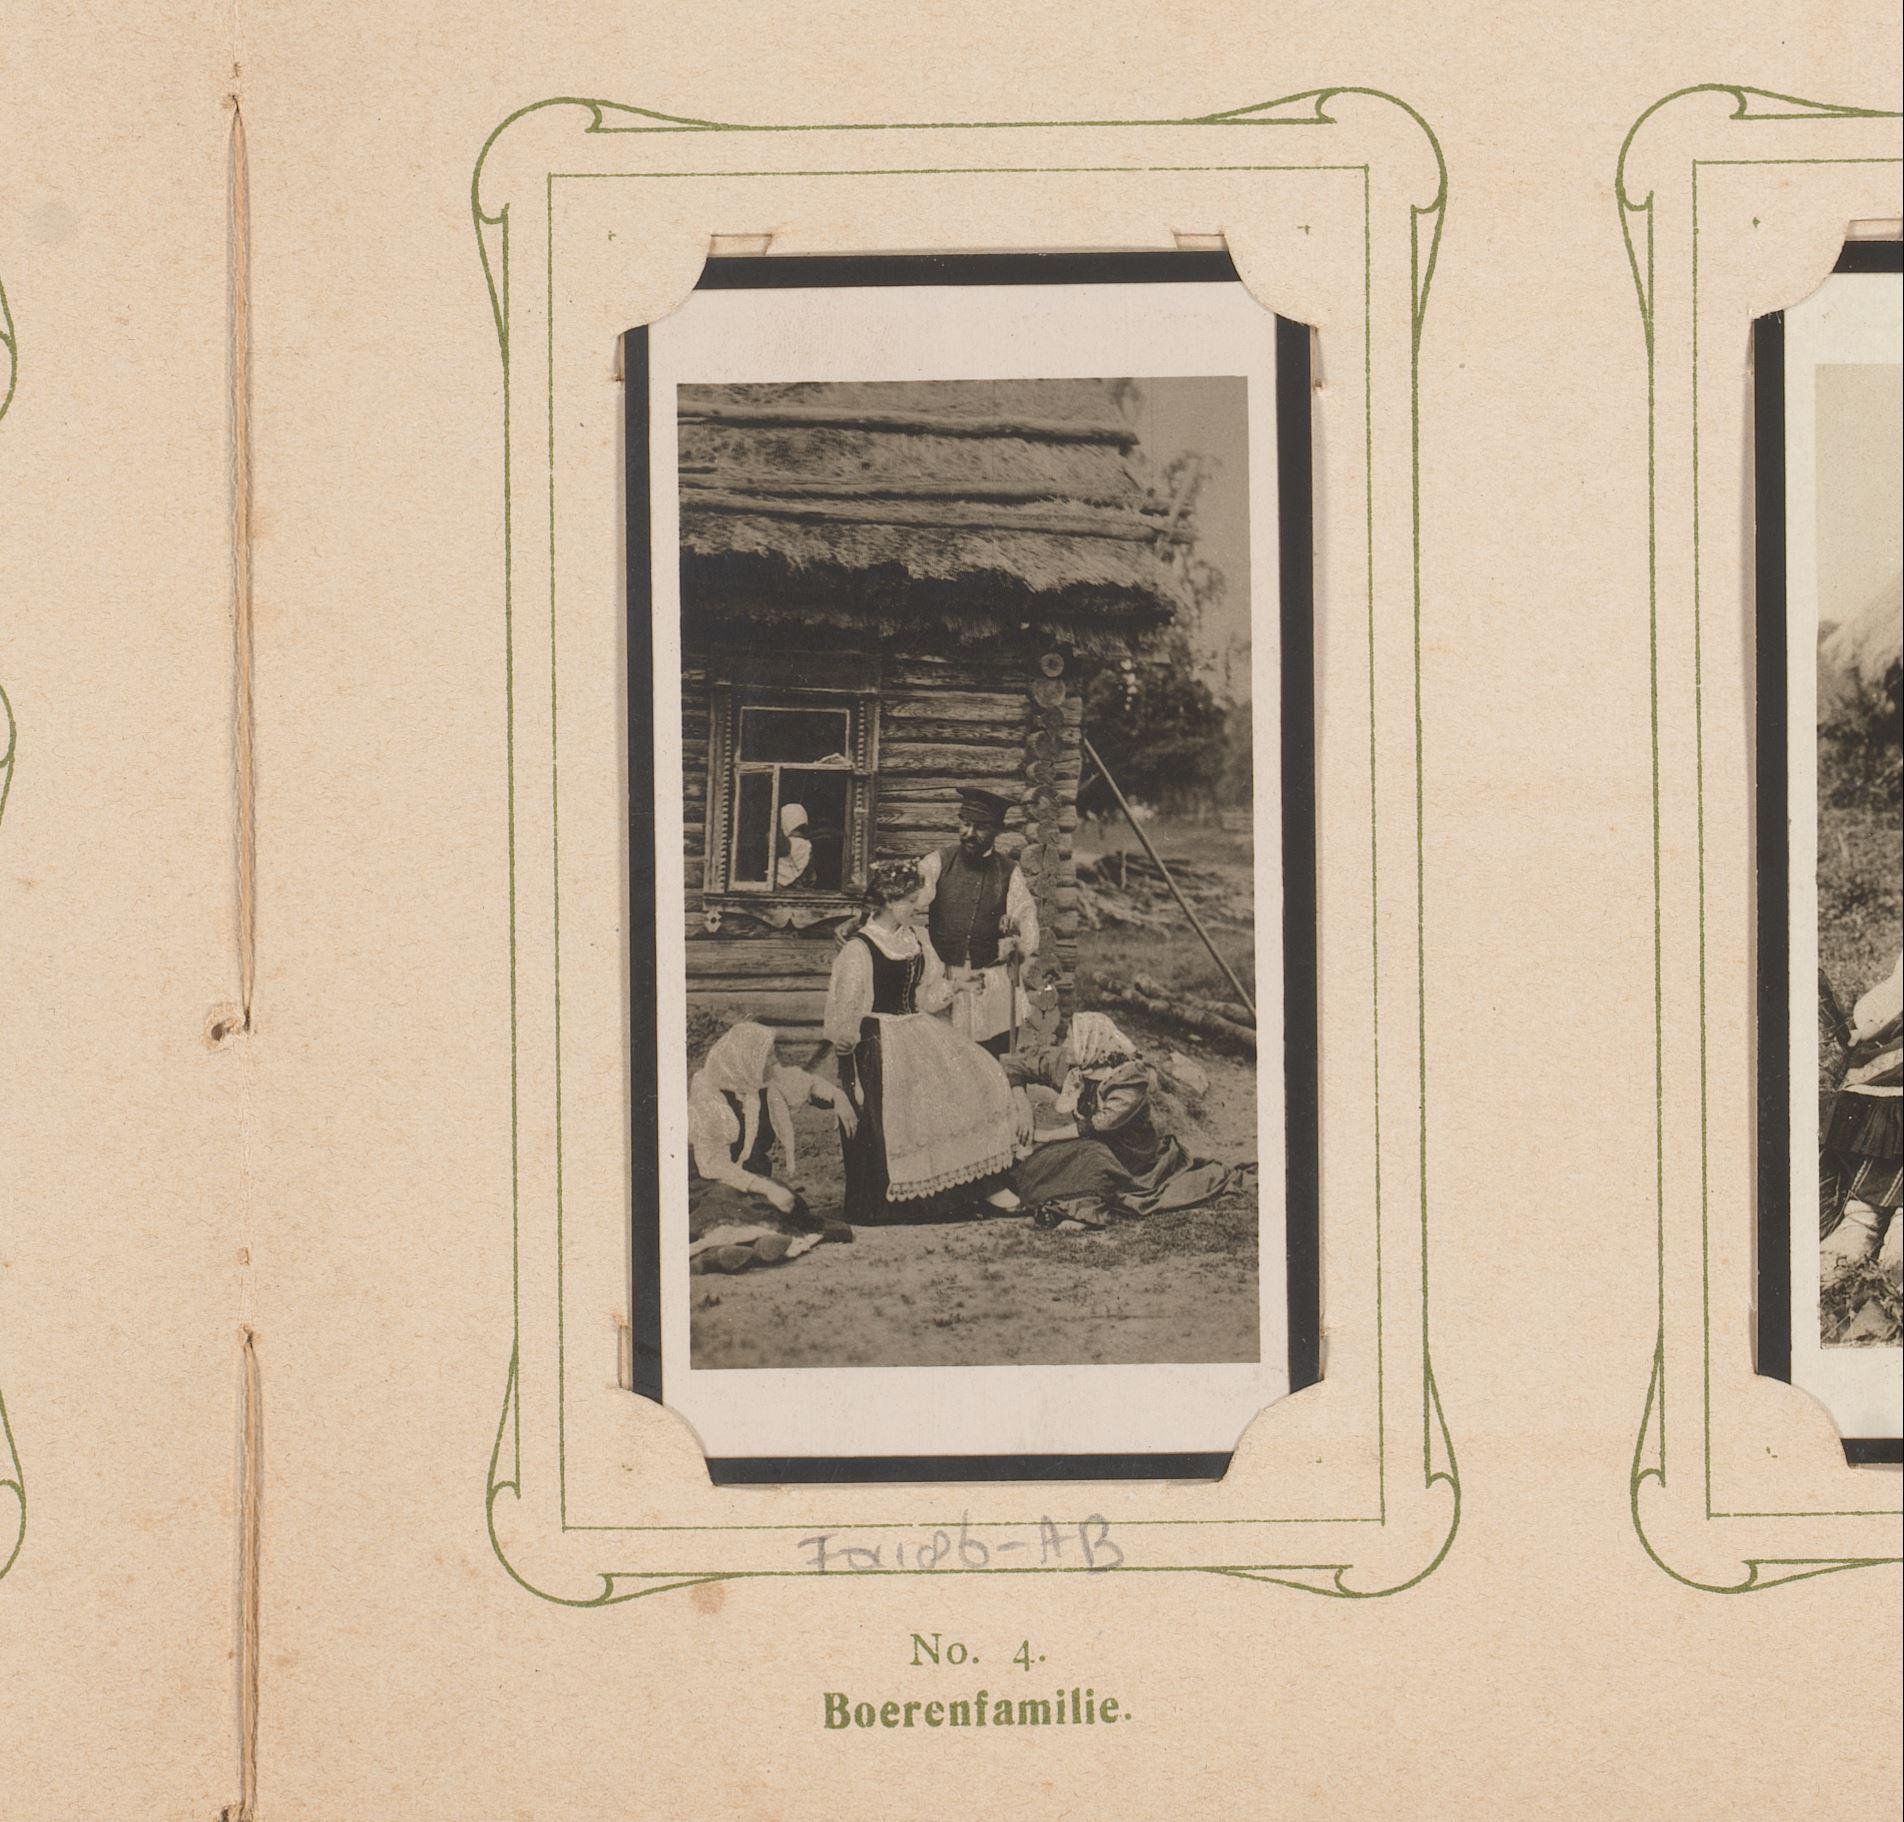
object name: album leaf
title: Russische boerenfamilie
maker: Anonymous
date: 1904-1905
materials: photographic support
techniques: gelatin silver print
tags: farmers, farm (building)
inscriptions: inscription: ‘No. 4./ Boerenfamilie’